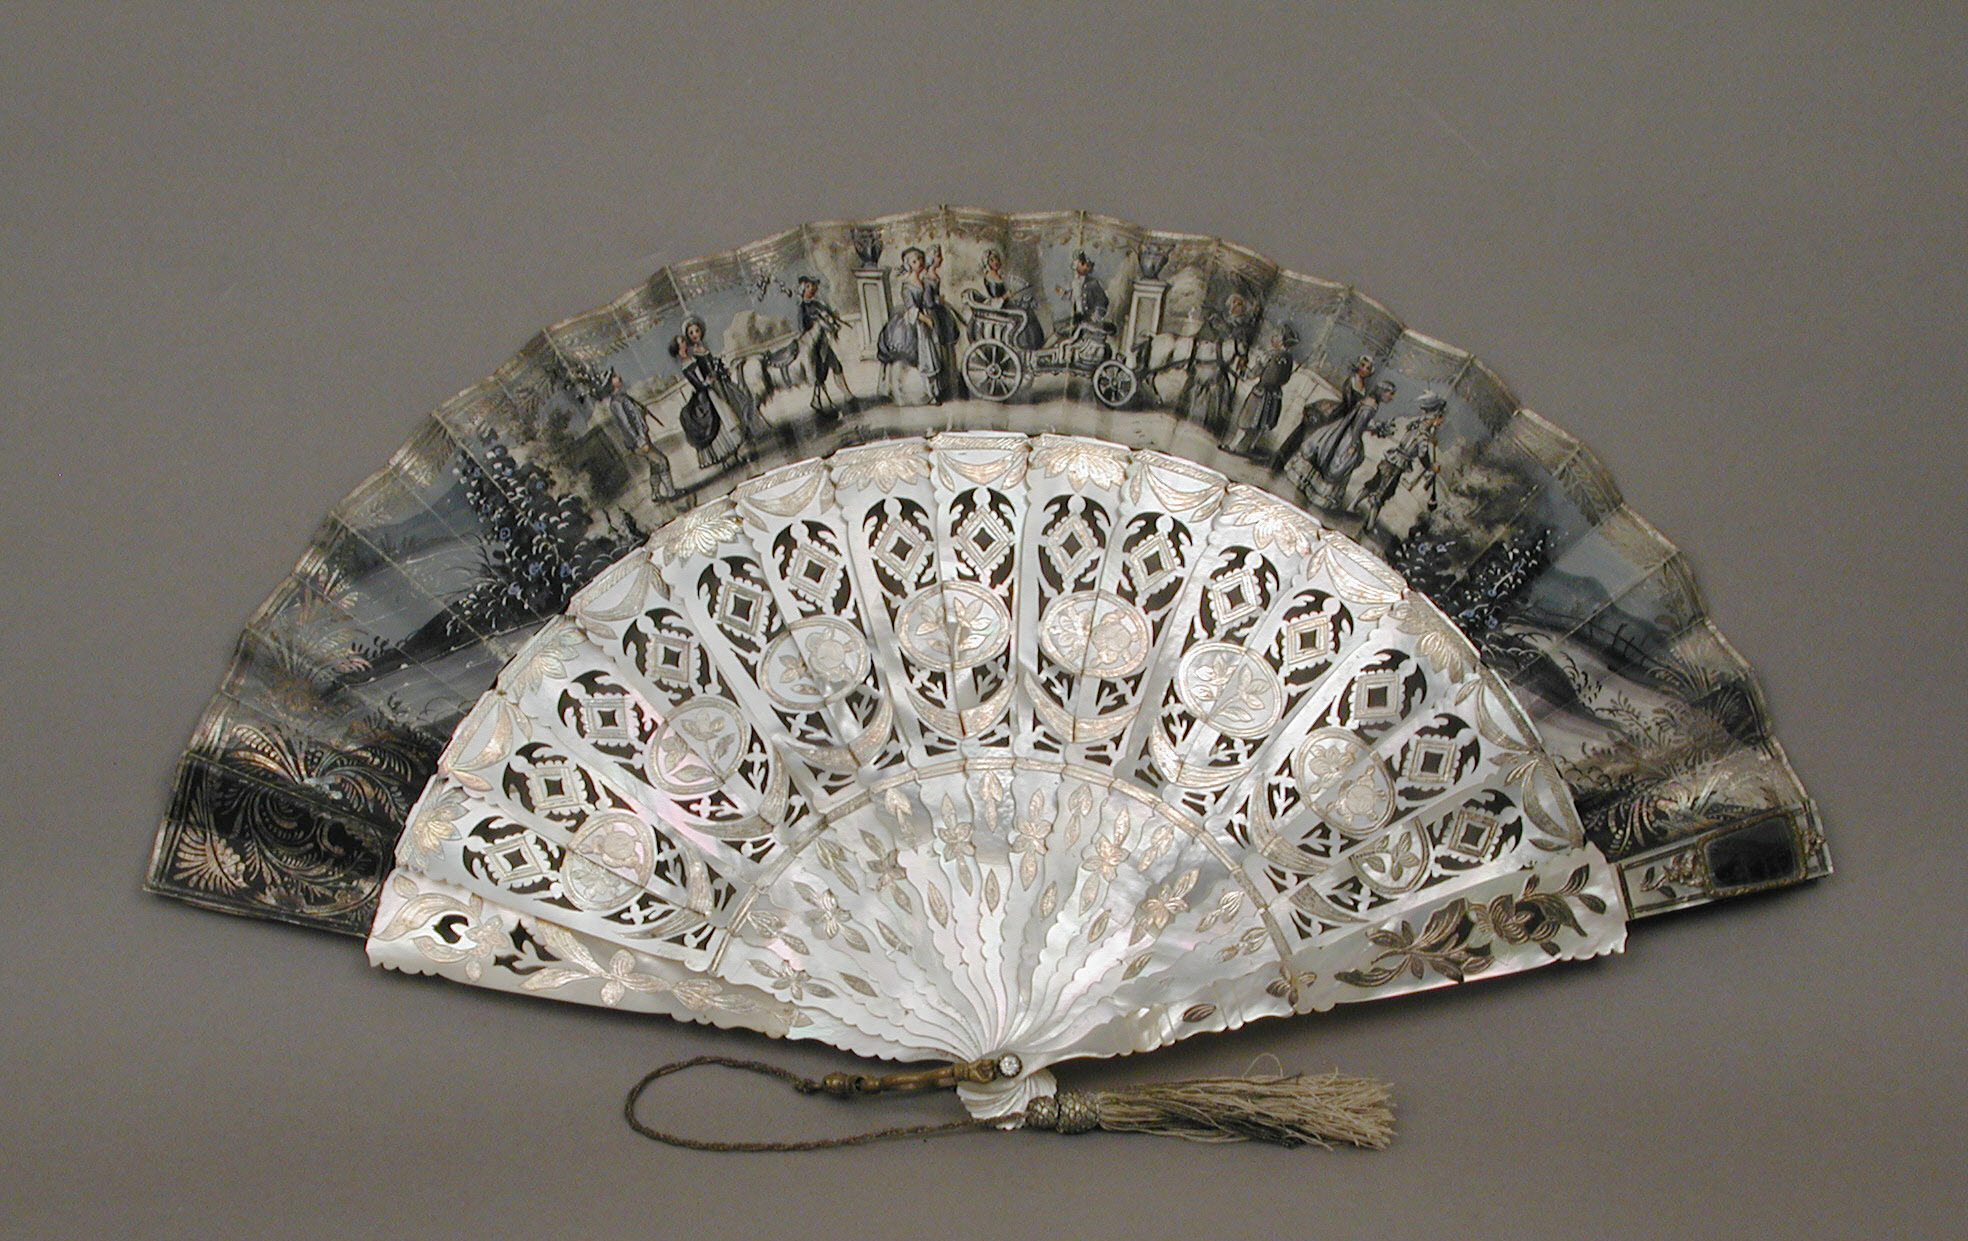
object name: fan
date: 1834-1866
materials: foil, glass, metal, mother of pearl, paint, paper, silver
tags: men,women,horses,carriages